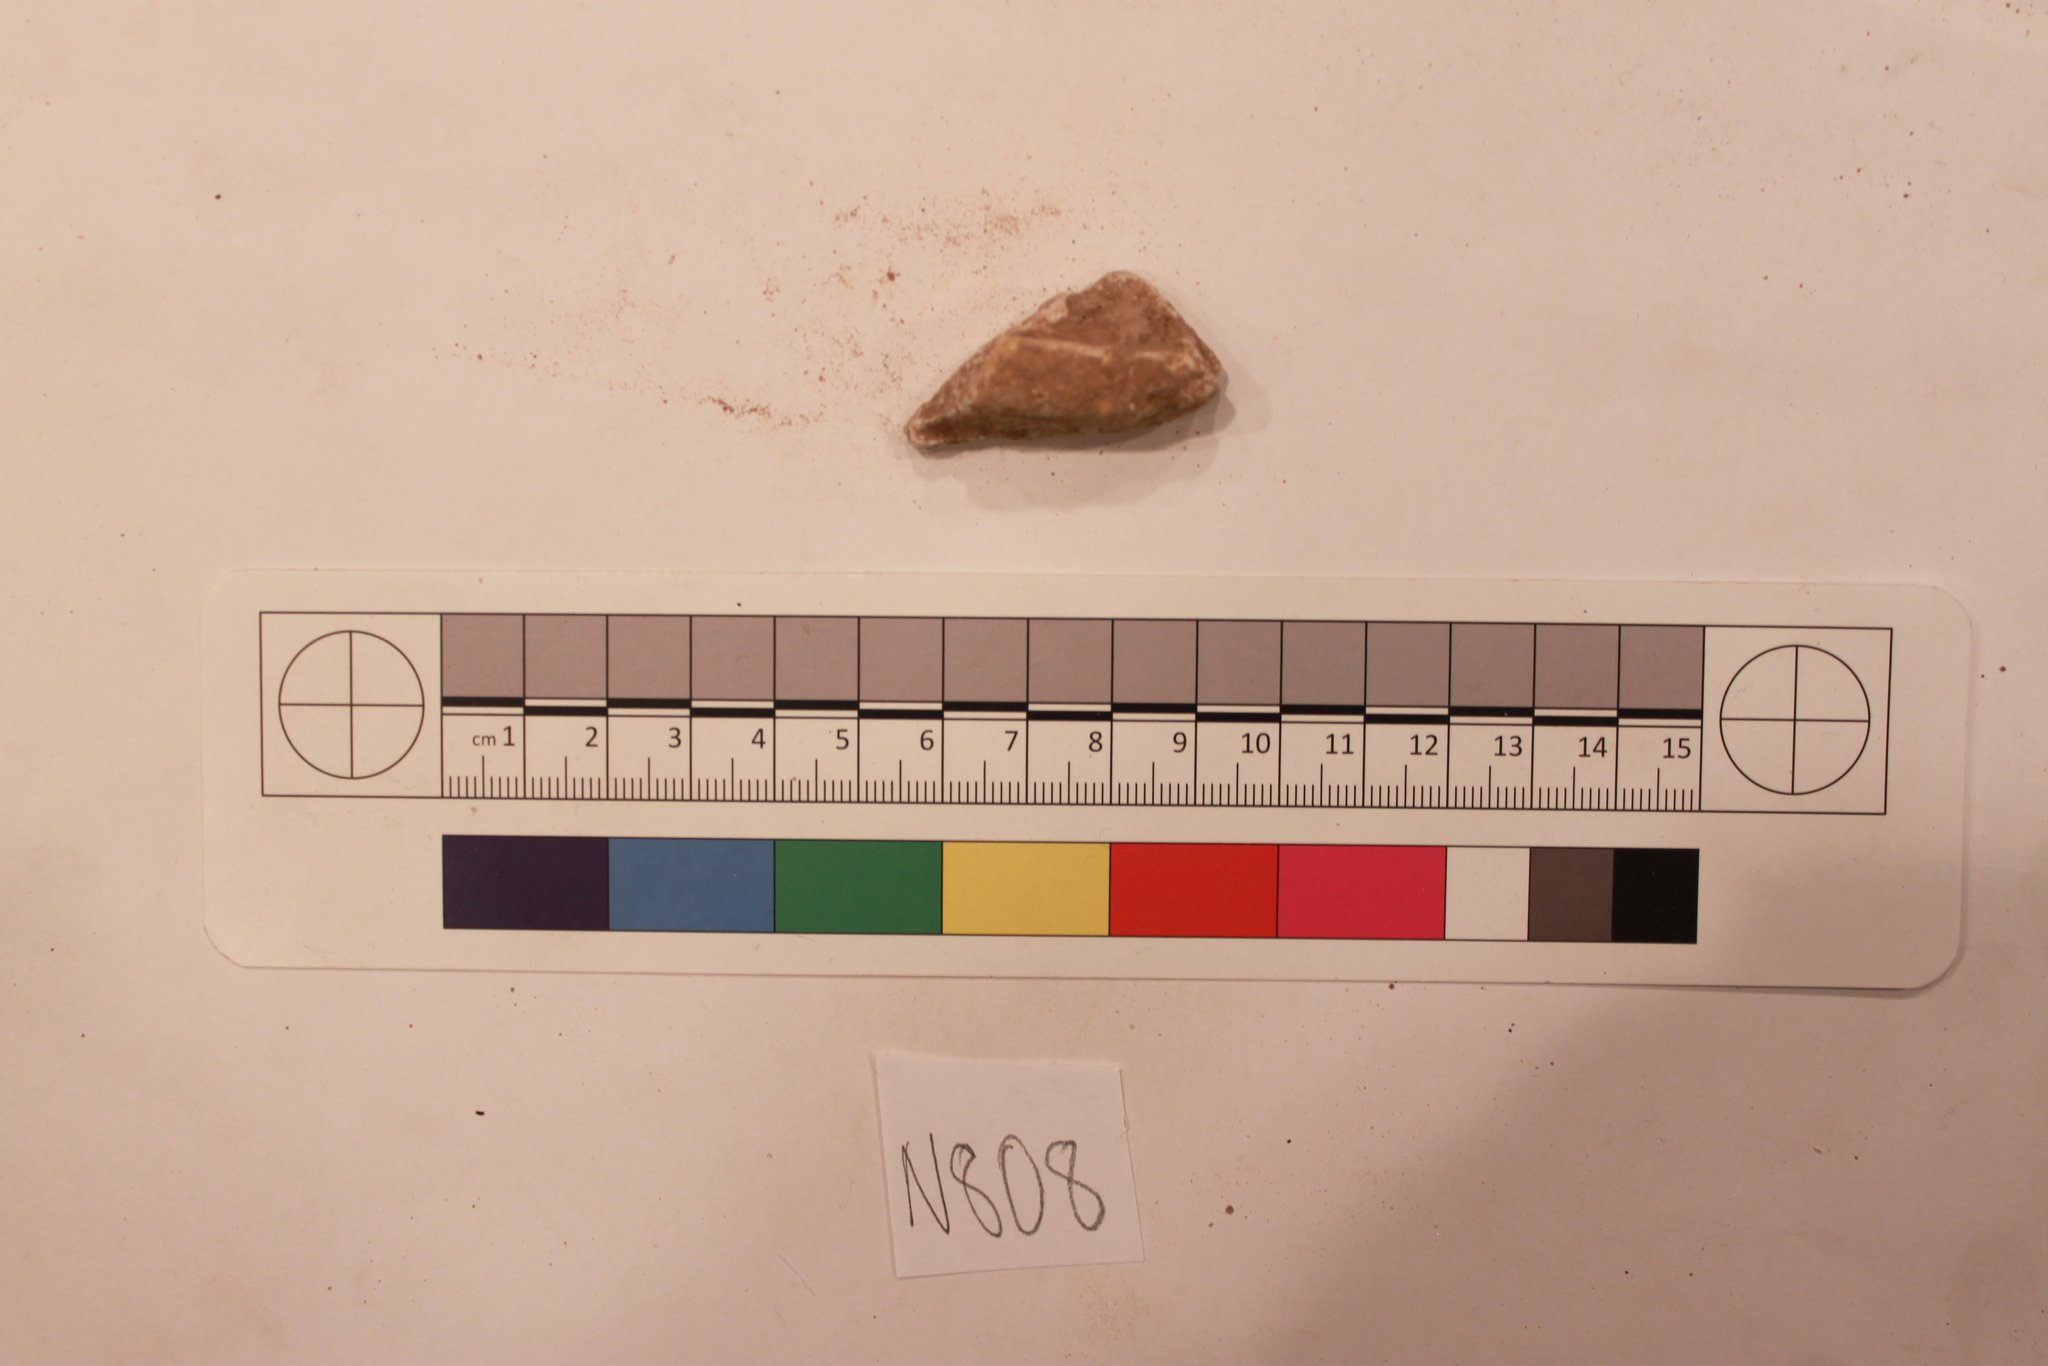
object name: fragment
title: Stucco Fragment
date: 701-1200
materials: plaster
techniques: carving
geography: iran